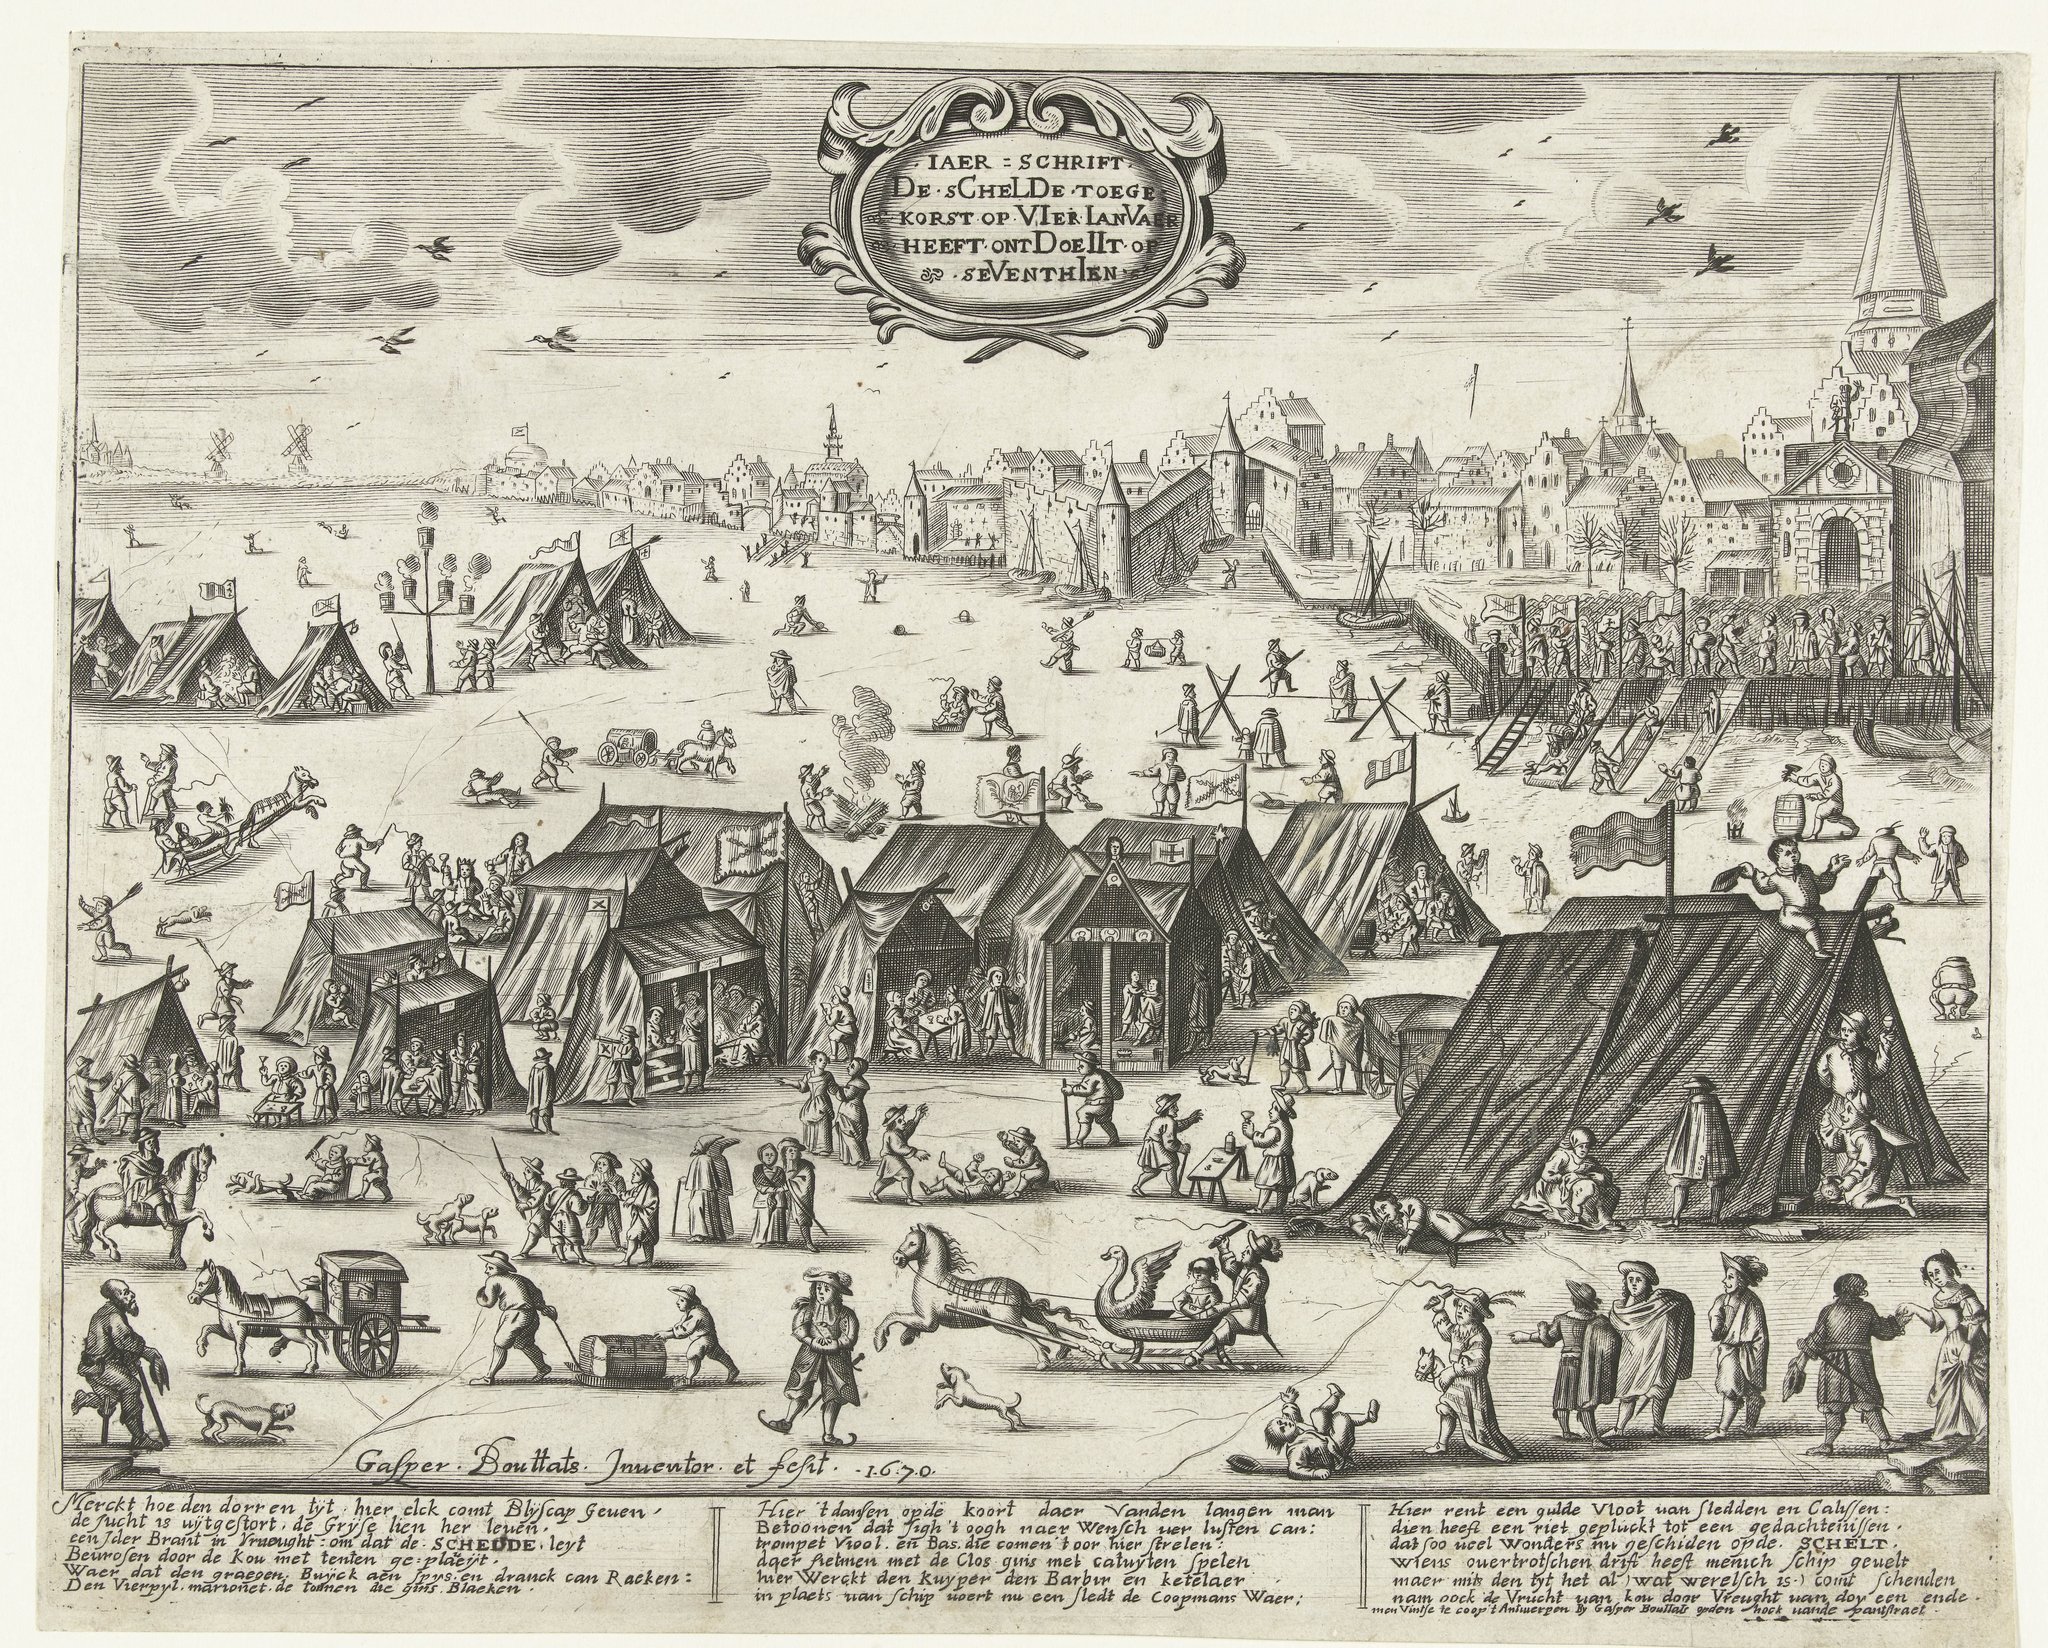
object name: print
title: IJsvermaak op de Schelde bij Antwerpen, 1670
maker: gaspar bouttats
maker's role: print maker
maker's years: 1640-1695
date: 1670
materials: paper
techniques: engraving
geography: antwerp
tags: winter sports, antwerp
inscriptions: date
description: IJsvermaak op de van 2 tot 17 januari bevroren Schelde bij Antwerpen, 1670. Met tenten op het ijs, schaatsers, sleden, koorddansen etc. Bovenaan een jaardicht voor het jaar 1670 in een cartouche. Met onderschrift in 3 kolommen.